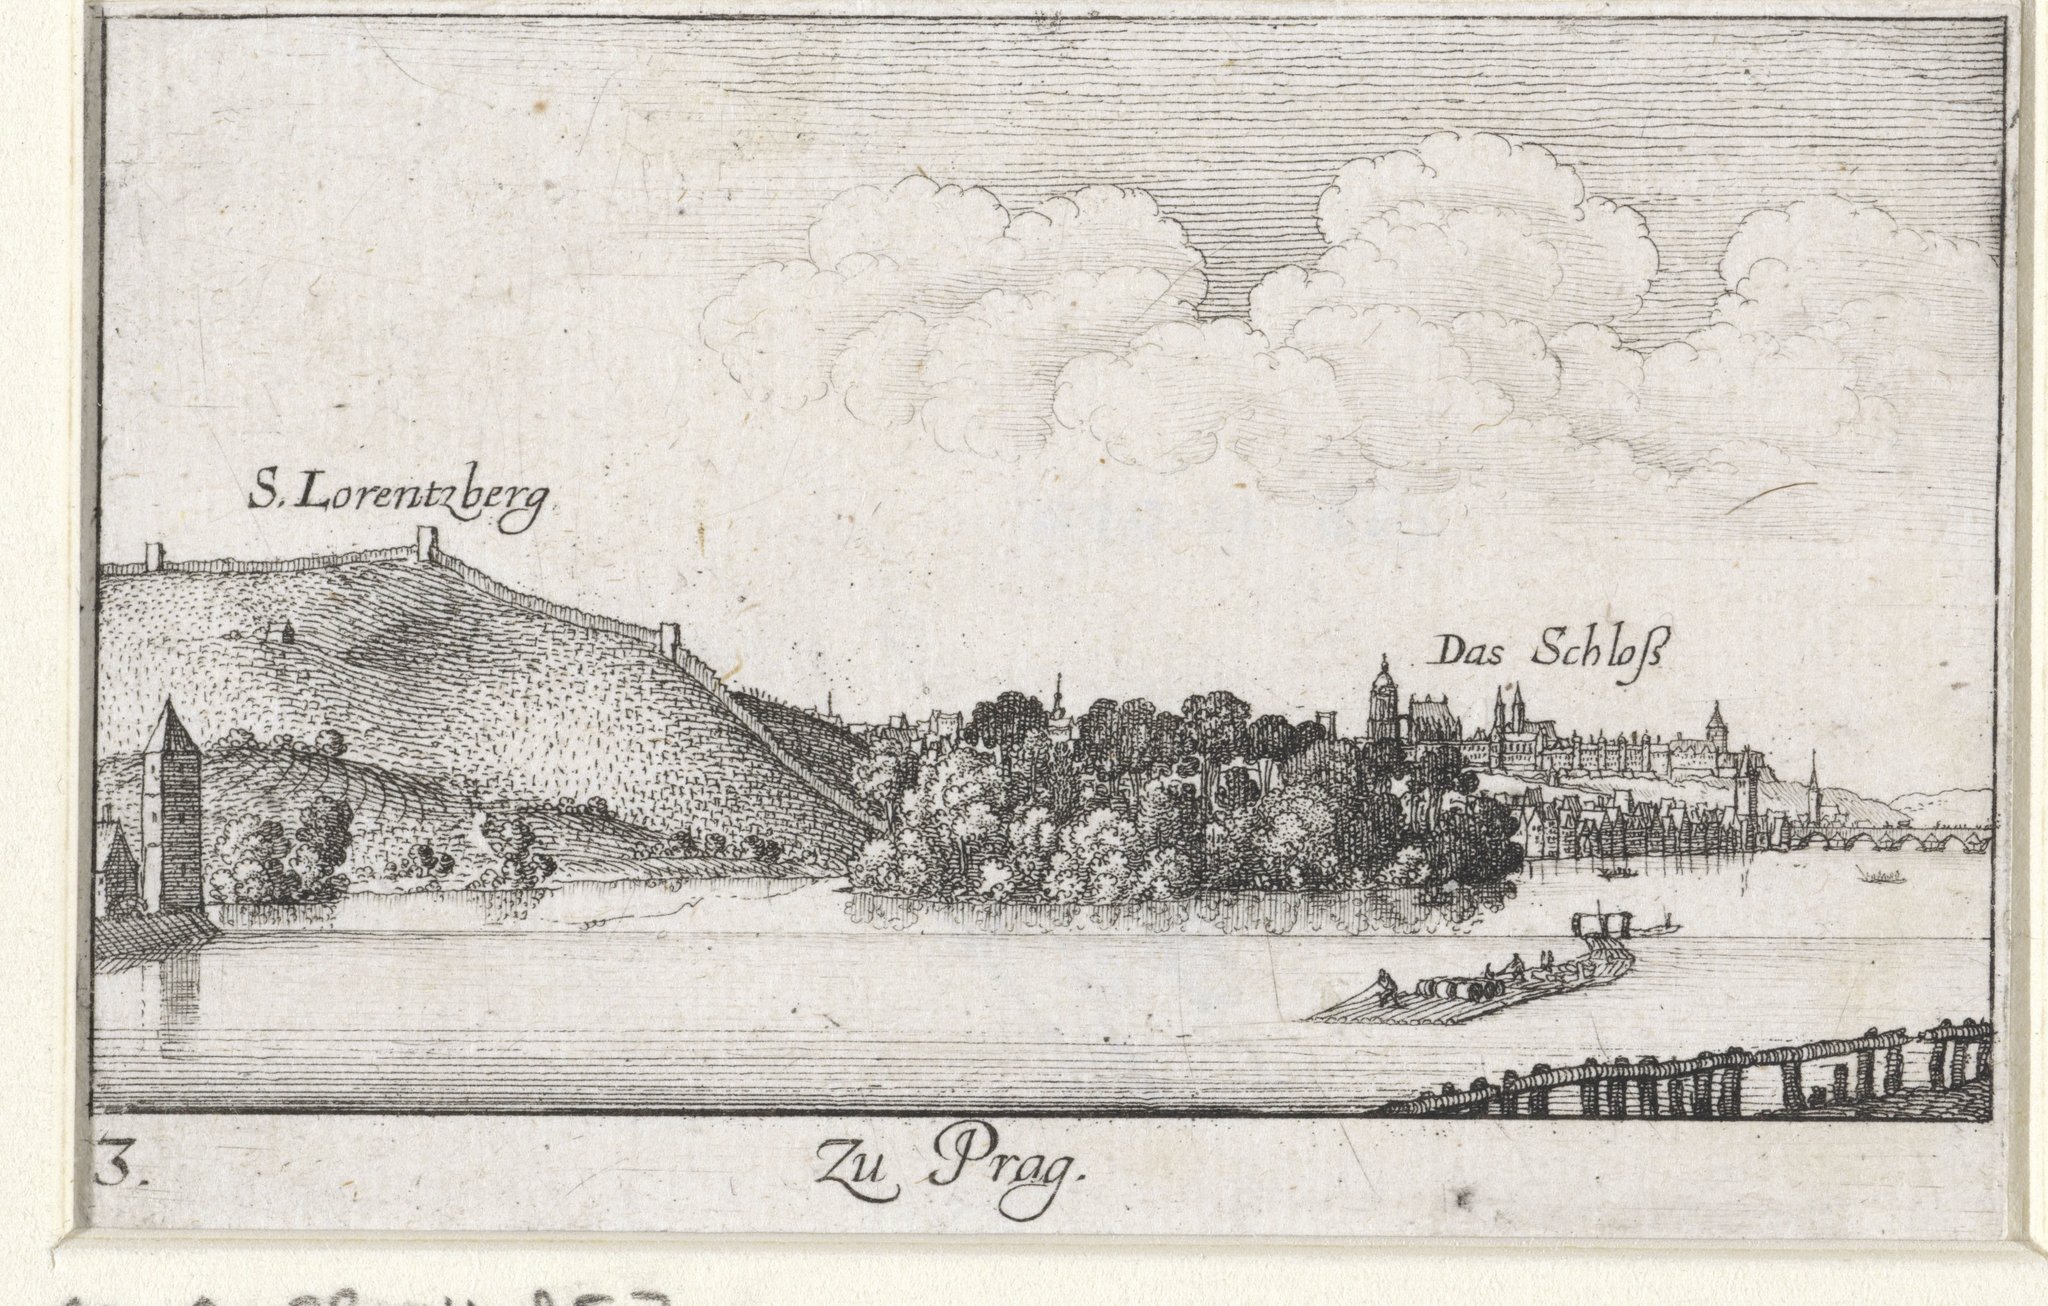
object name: print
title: Zu Prag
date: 1635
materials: paper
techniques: etching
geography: cologne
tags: city-view, and landscape with man-made constructions, prague